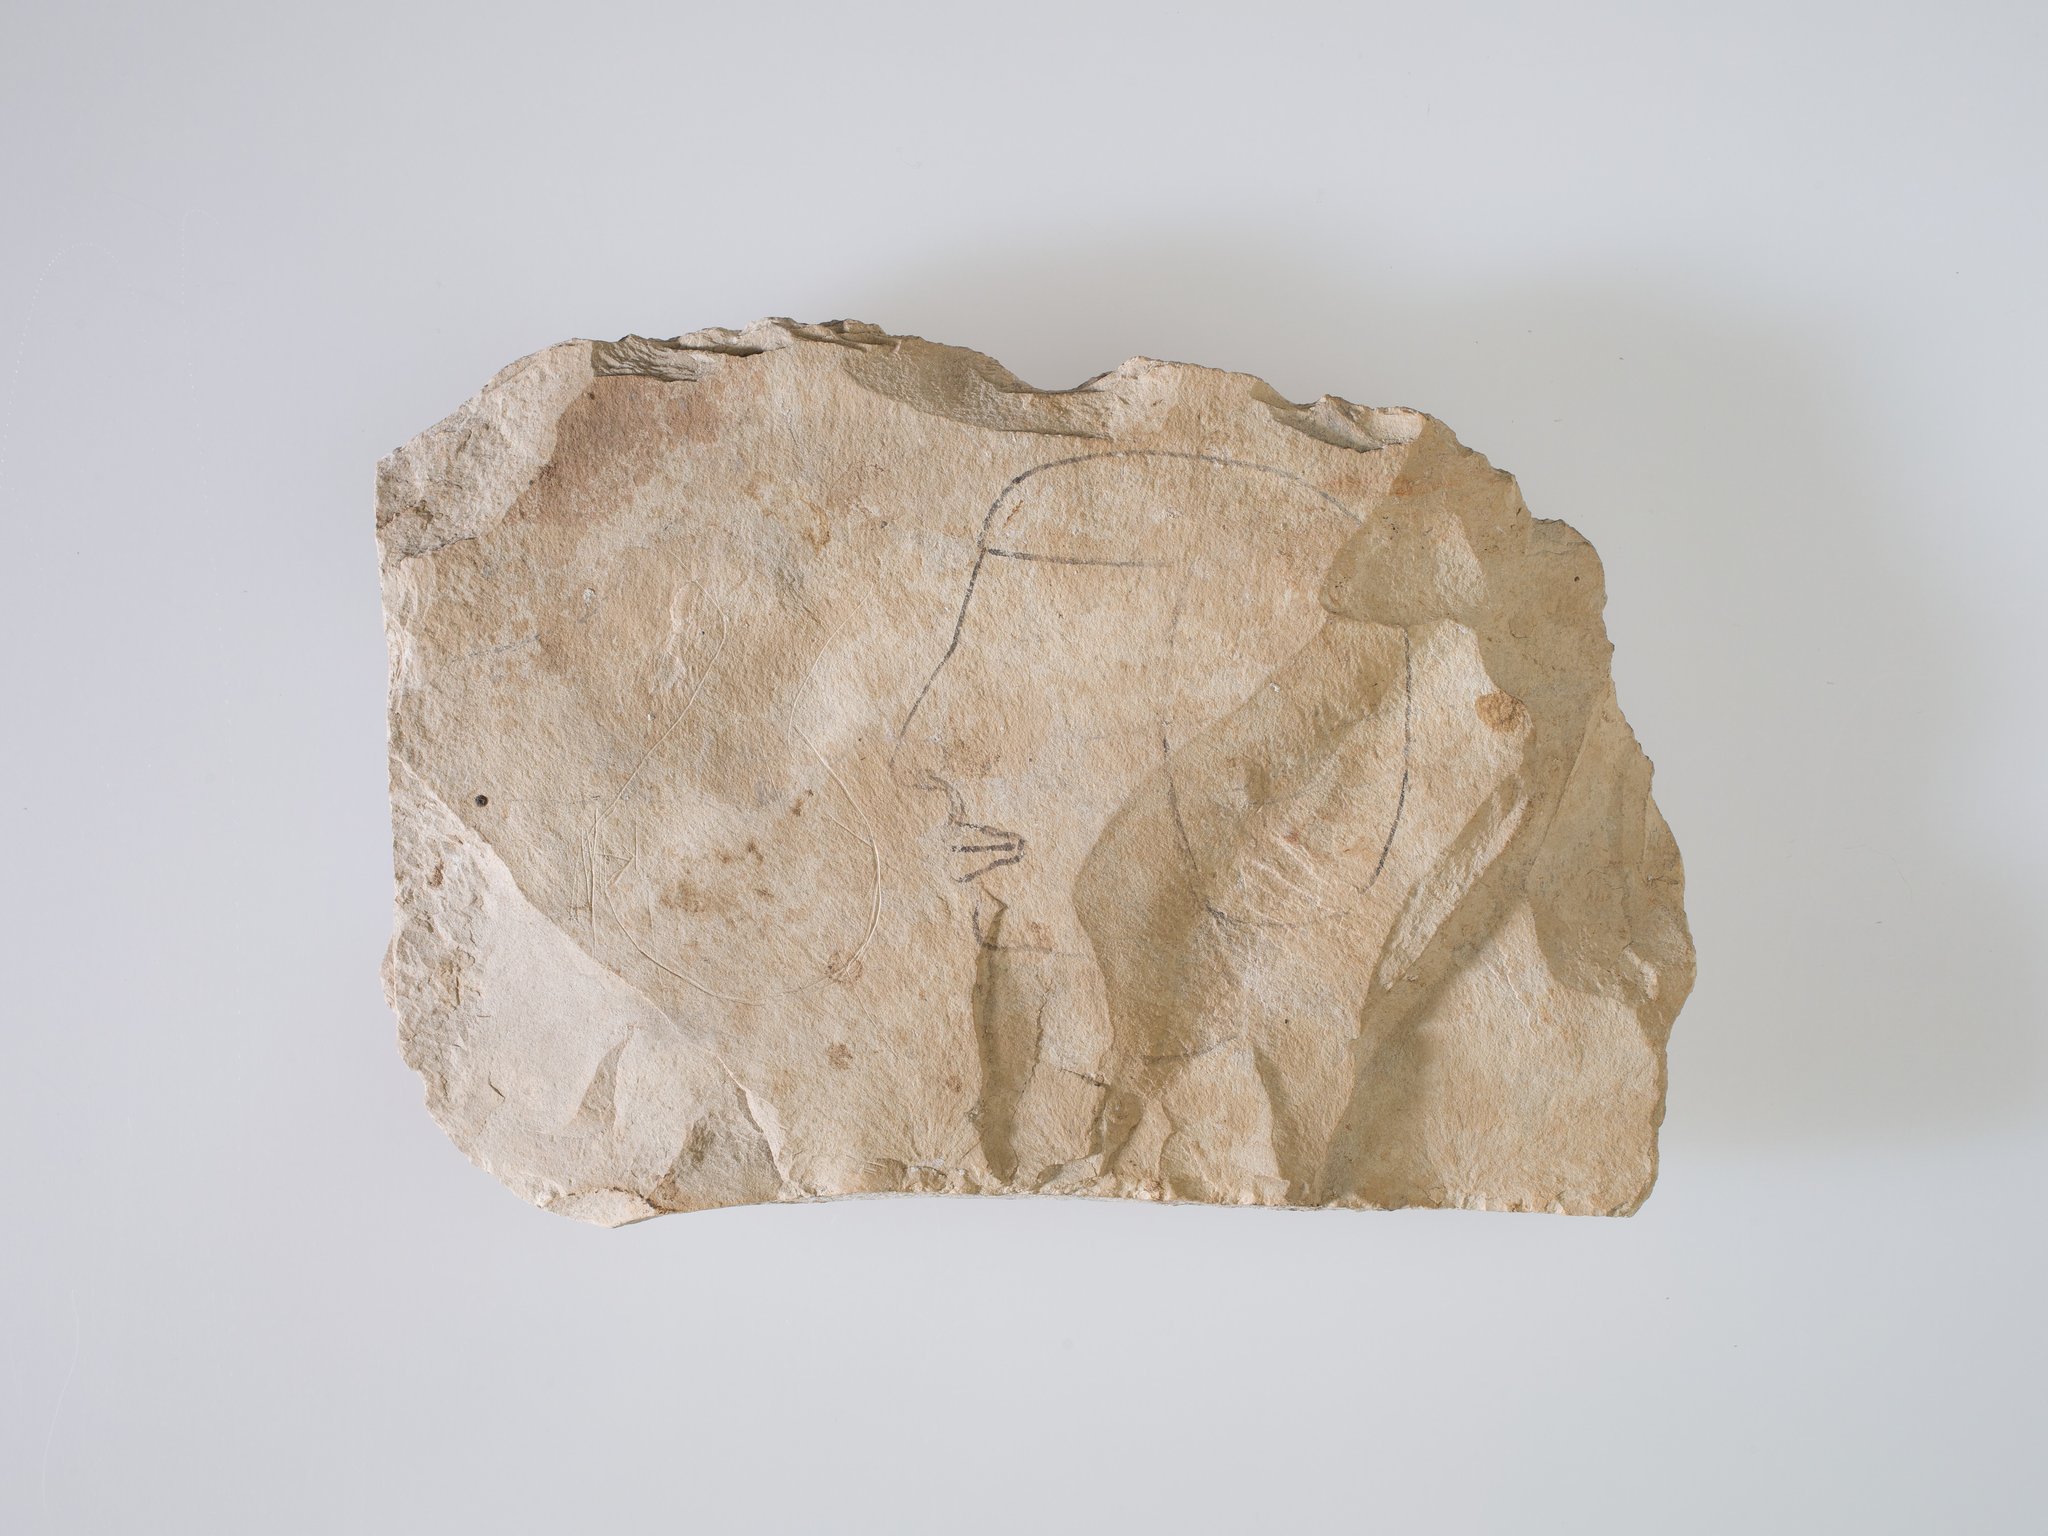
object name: ostracon, figured, senenmut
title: Ostracon Depicting a Man's Head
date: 1479-1458 BCE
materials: ink, limestone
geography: egypt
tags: heads,men